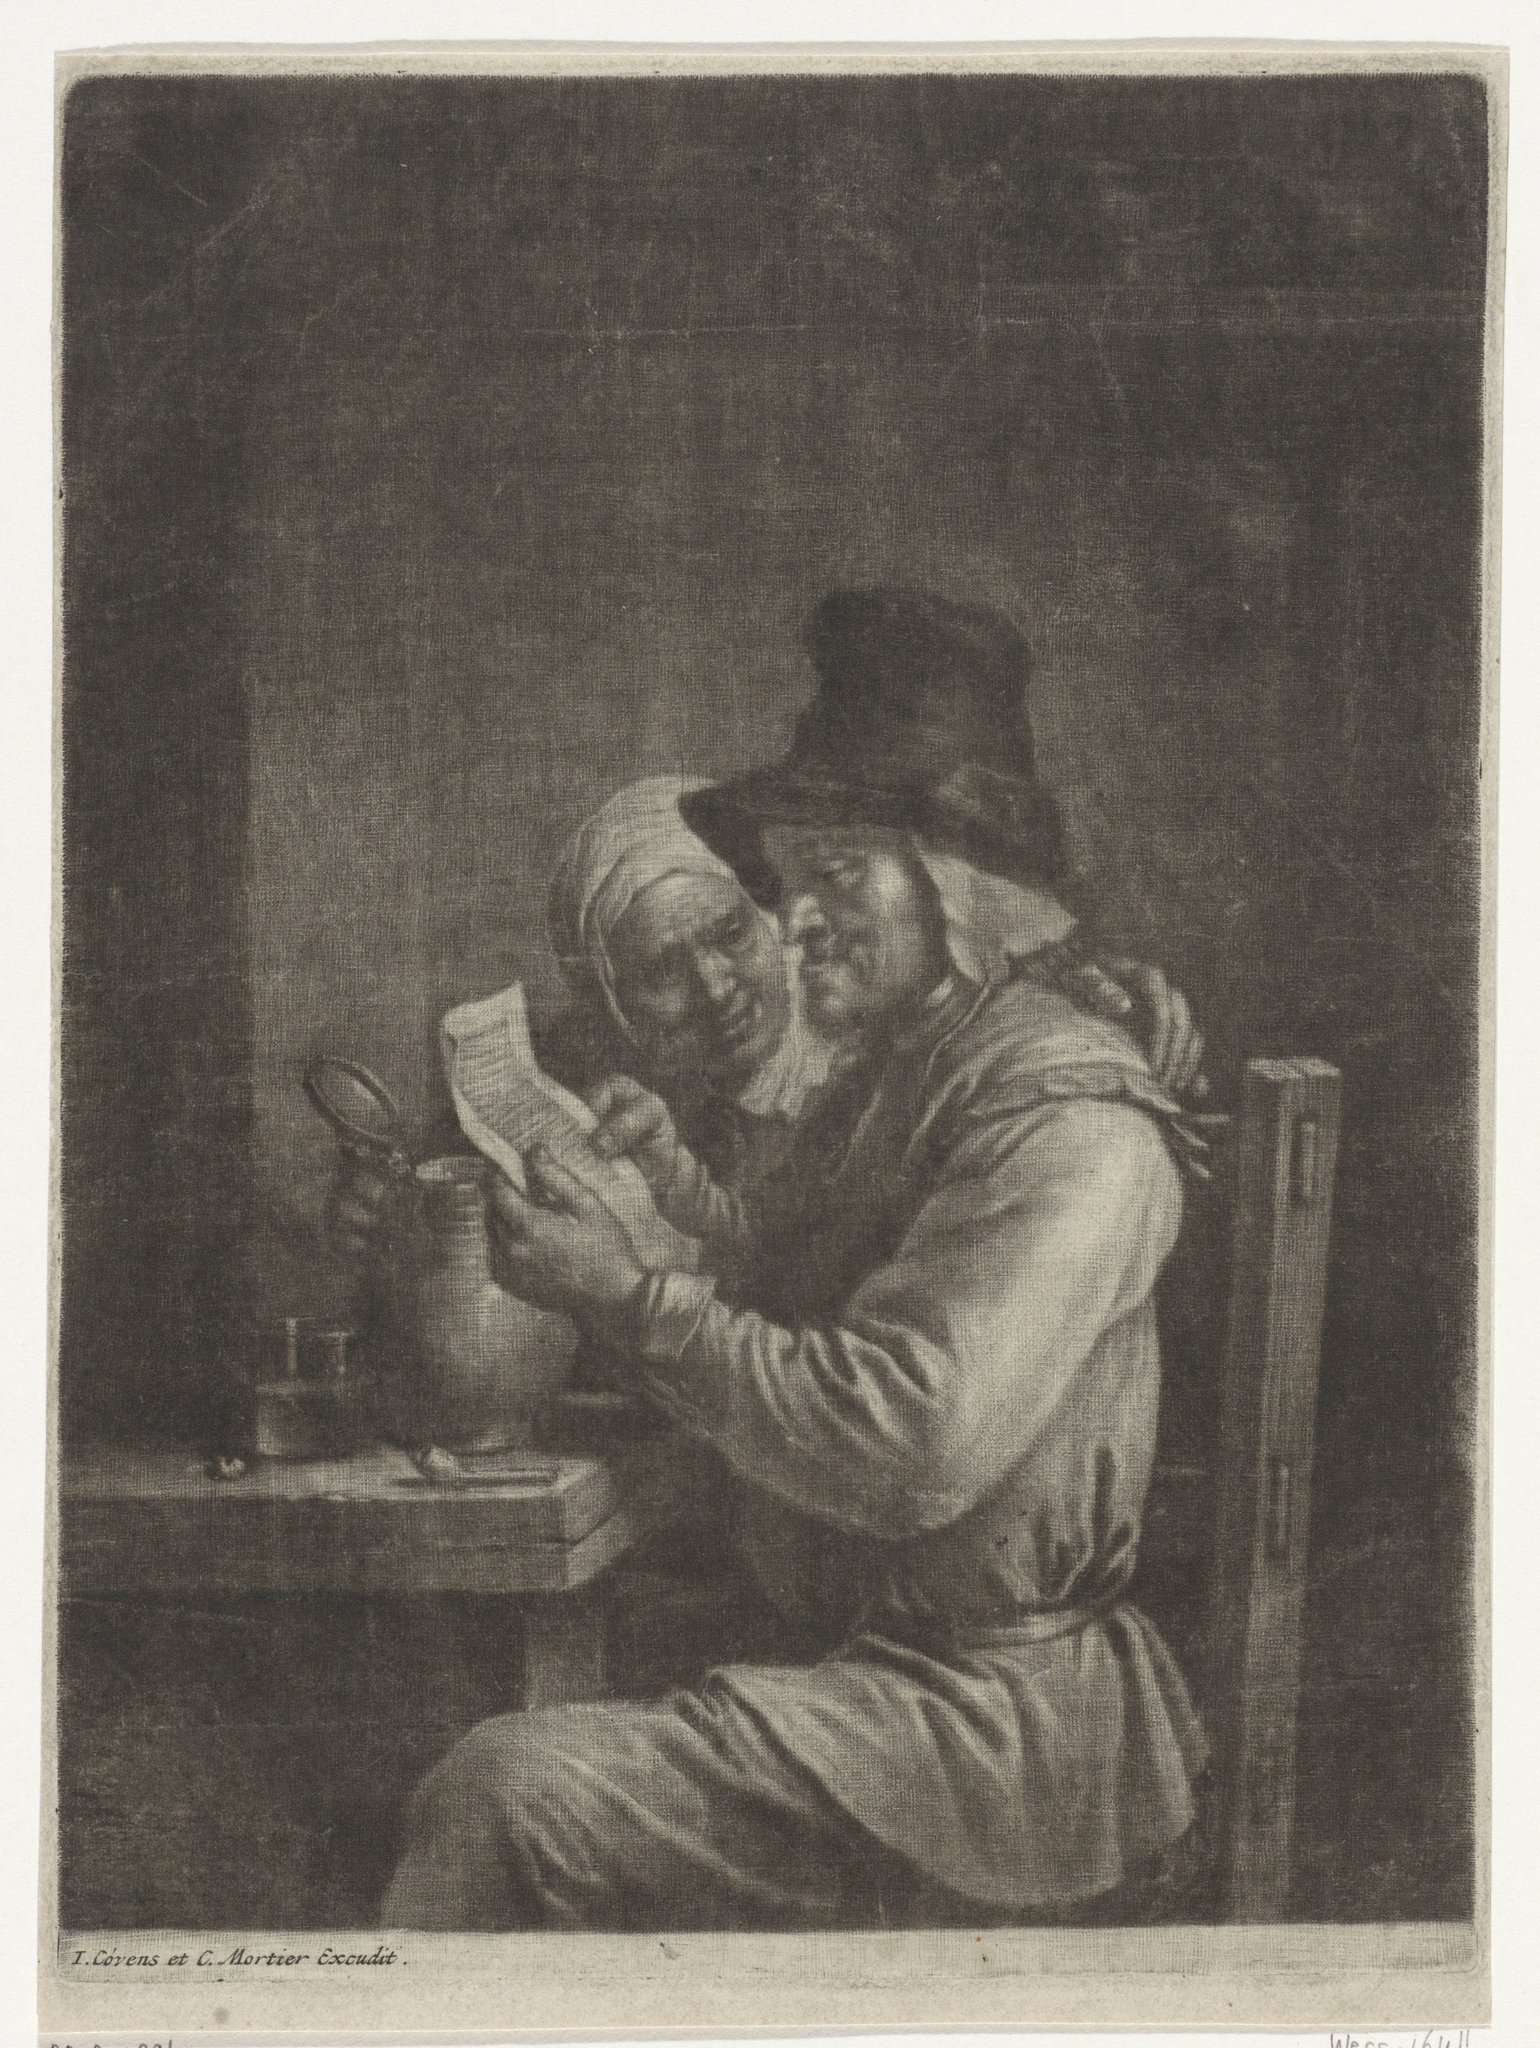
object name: print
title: Brief lezende man en vrouw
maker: wallerant vaillant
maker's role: draughtsman, painter, print maker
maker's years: 1623-1677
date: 1658-1677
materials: paper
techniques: mezzotint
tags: reading, interior of the house, letter, envelope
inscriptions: collector's mark: Lugt 2228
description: Een man en een vrouw zitten aan een tafel en lezen samen een brief. Op de tafel een pijpje, een glas en een kruik.